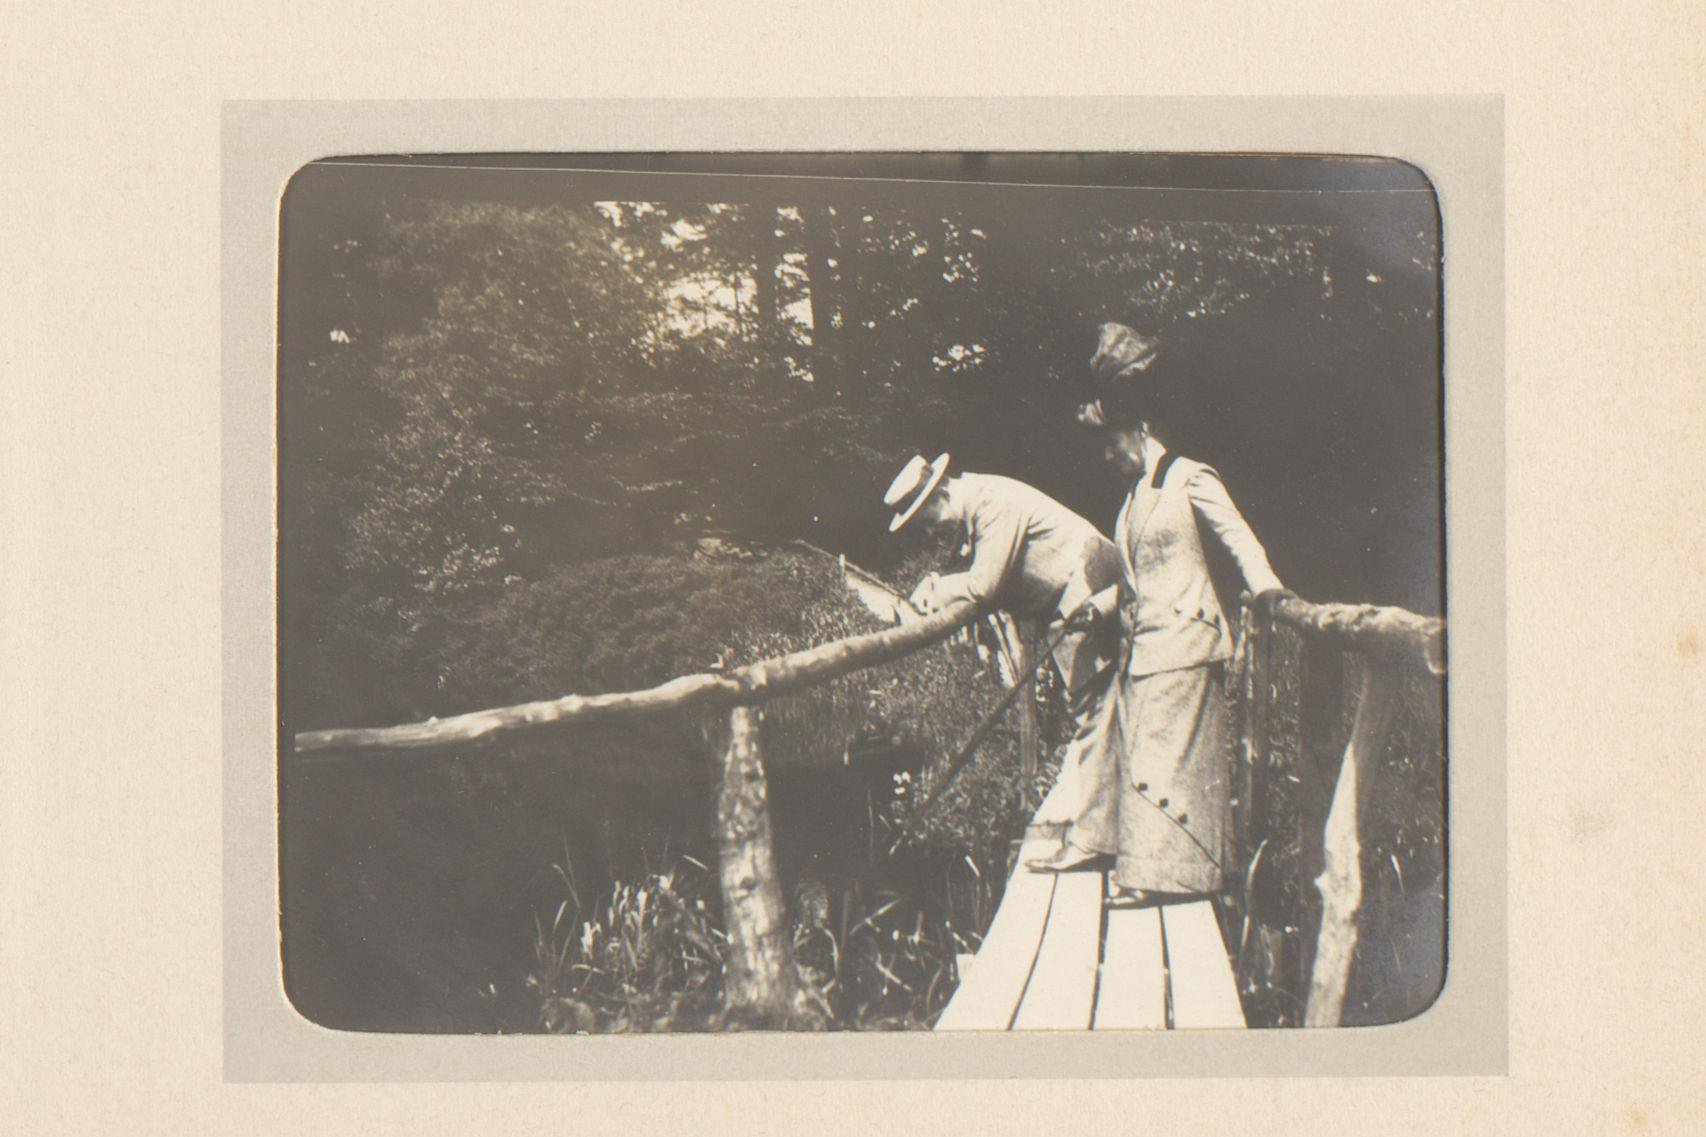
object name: photograph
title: Man en vrouw op een houten loopbrug over een beek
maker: liesbeth overhoff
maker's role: fotograaf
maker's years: 1895-1969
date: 1911-1912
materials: paper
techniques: gelatin silver print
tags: adult woman, adult man, brook, bridge